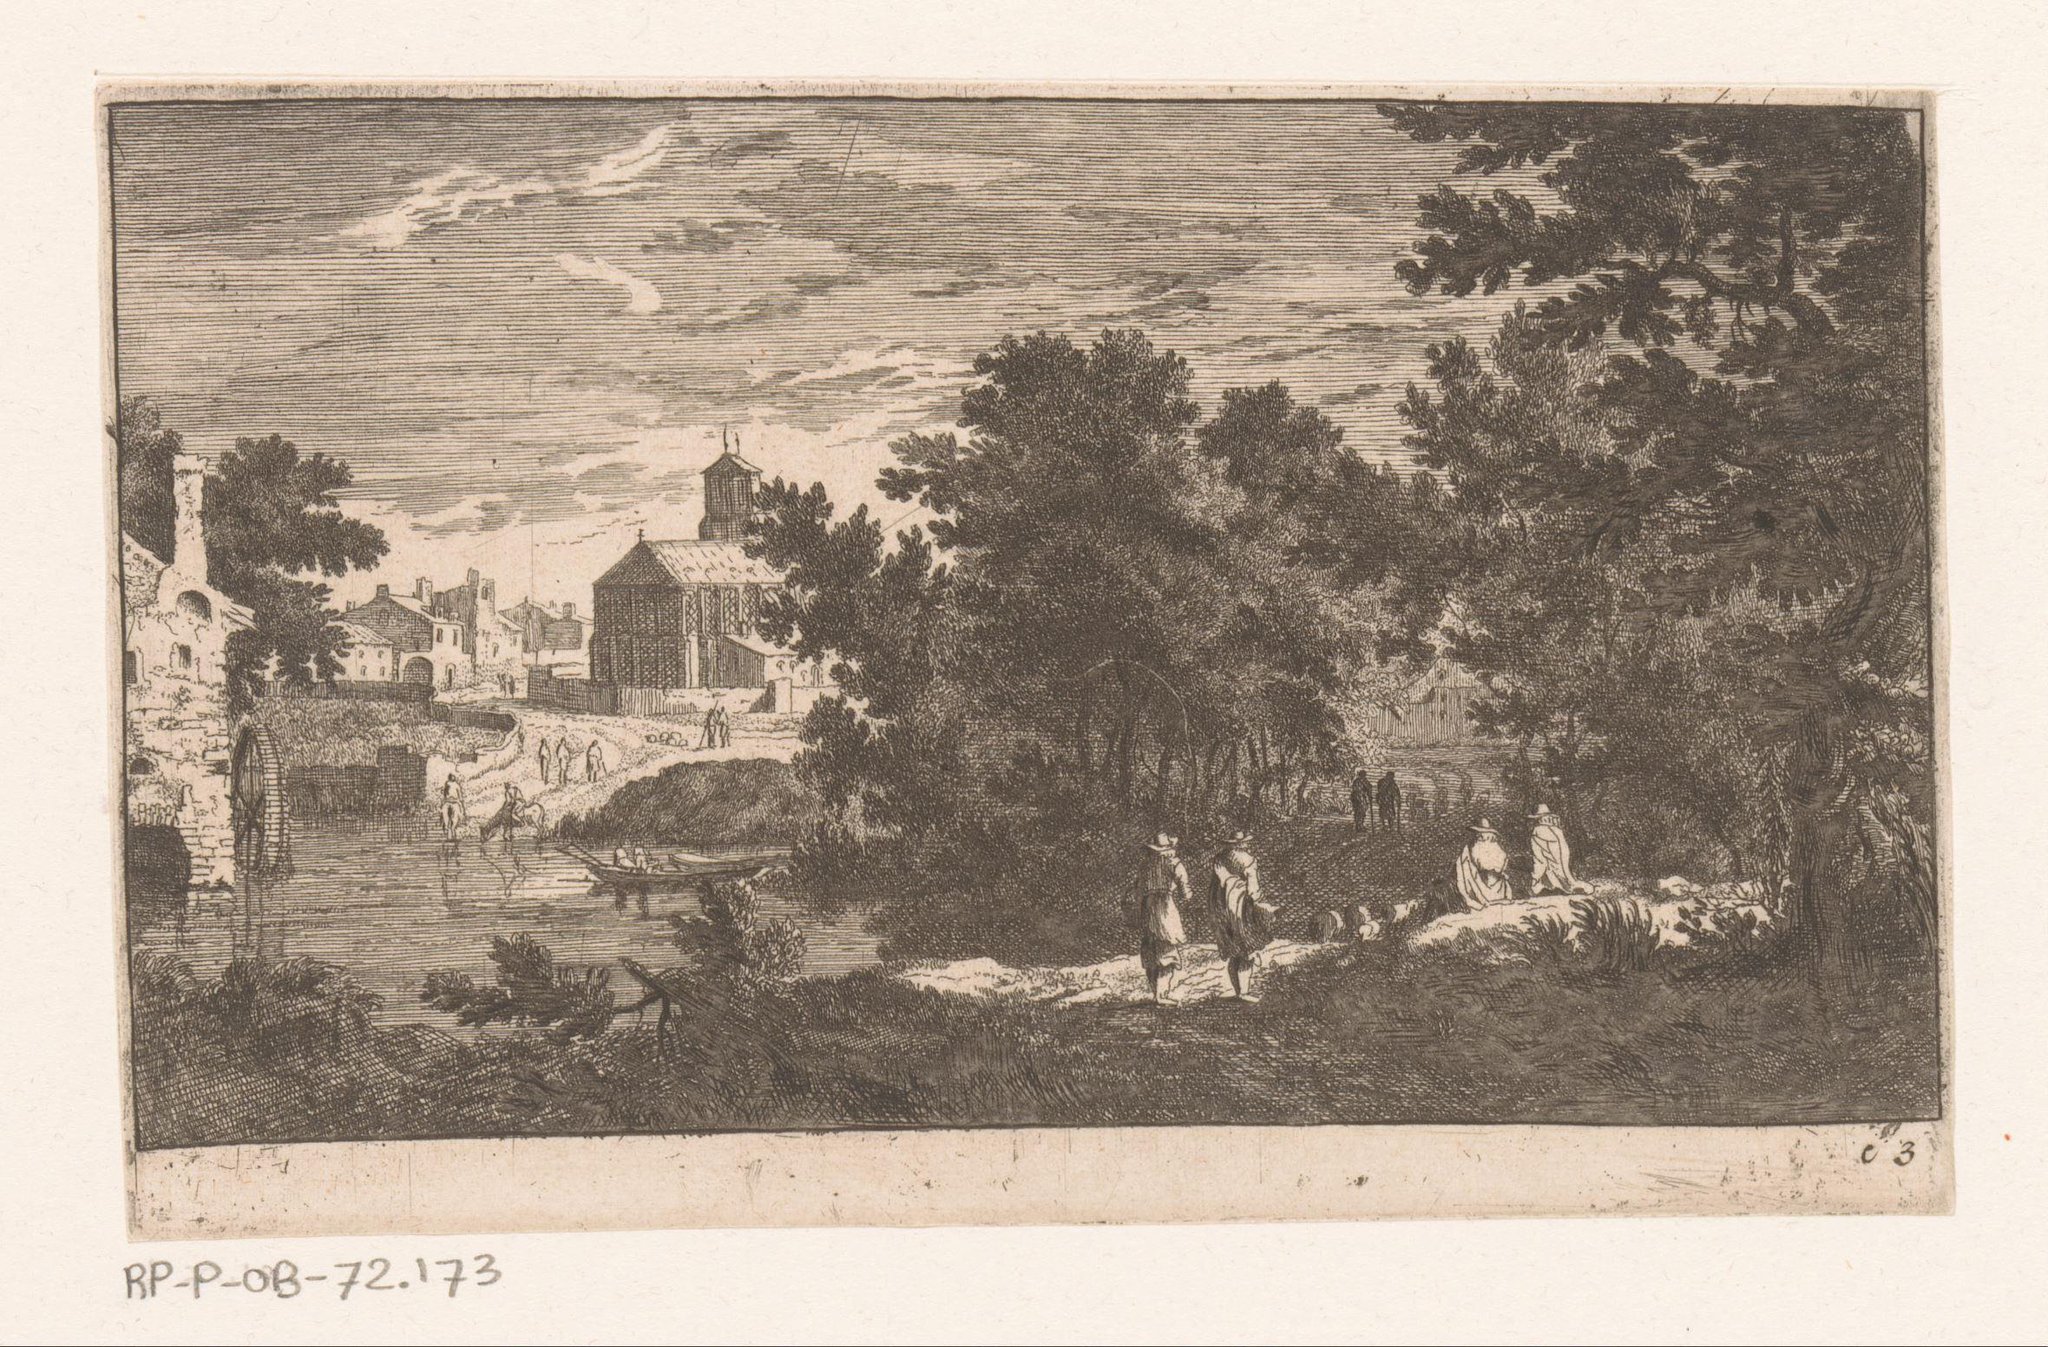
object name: print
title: Gezicht op dorp en watermolen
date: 1613-1695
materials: paper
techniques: etching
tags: watermill in landscape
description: Prenten met het signatuur 'Perelle' kunnen zowel door vader Gabriel als door zonen Nicolas en Adam gemaakt zijn.